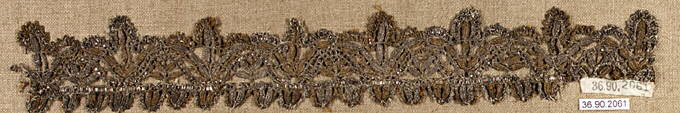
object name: piece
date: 1701-1800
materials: metal thread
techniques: lace